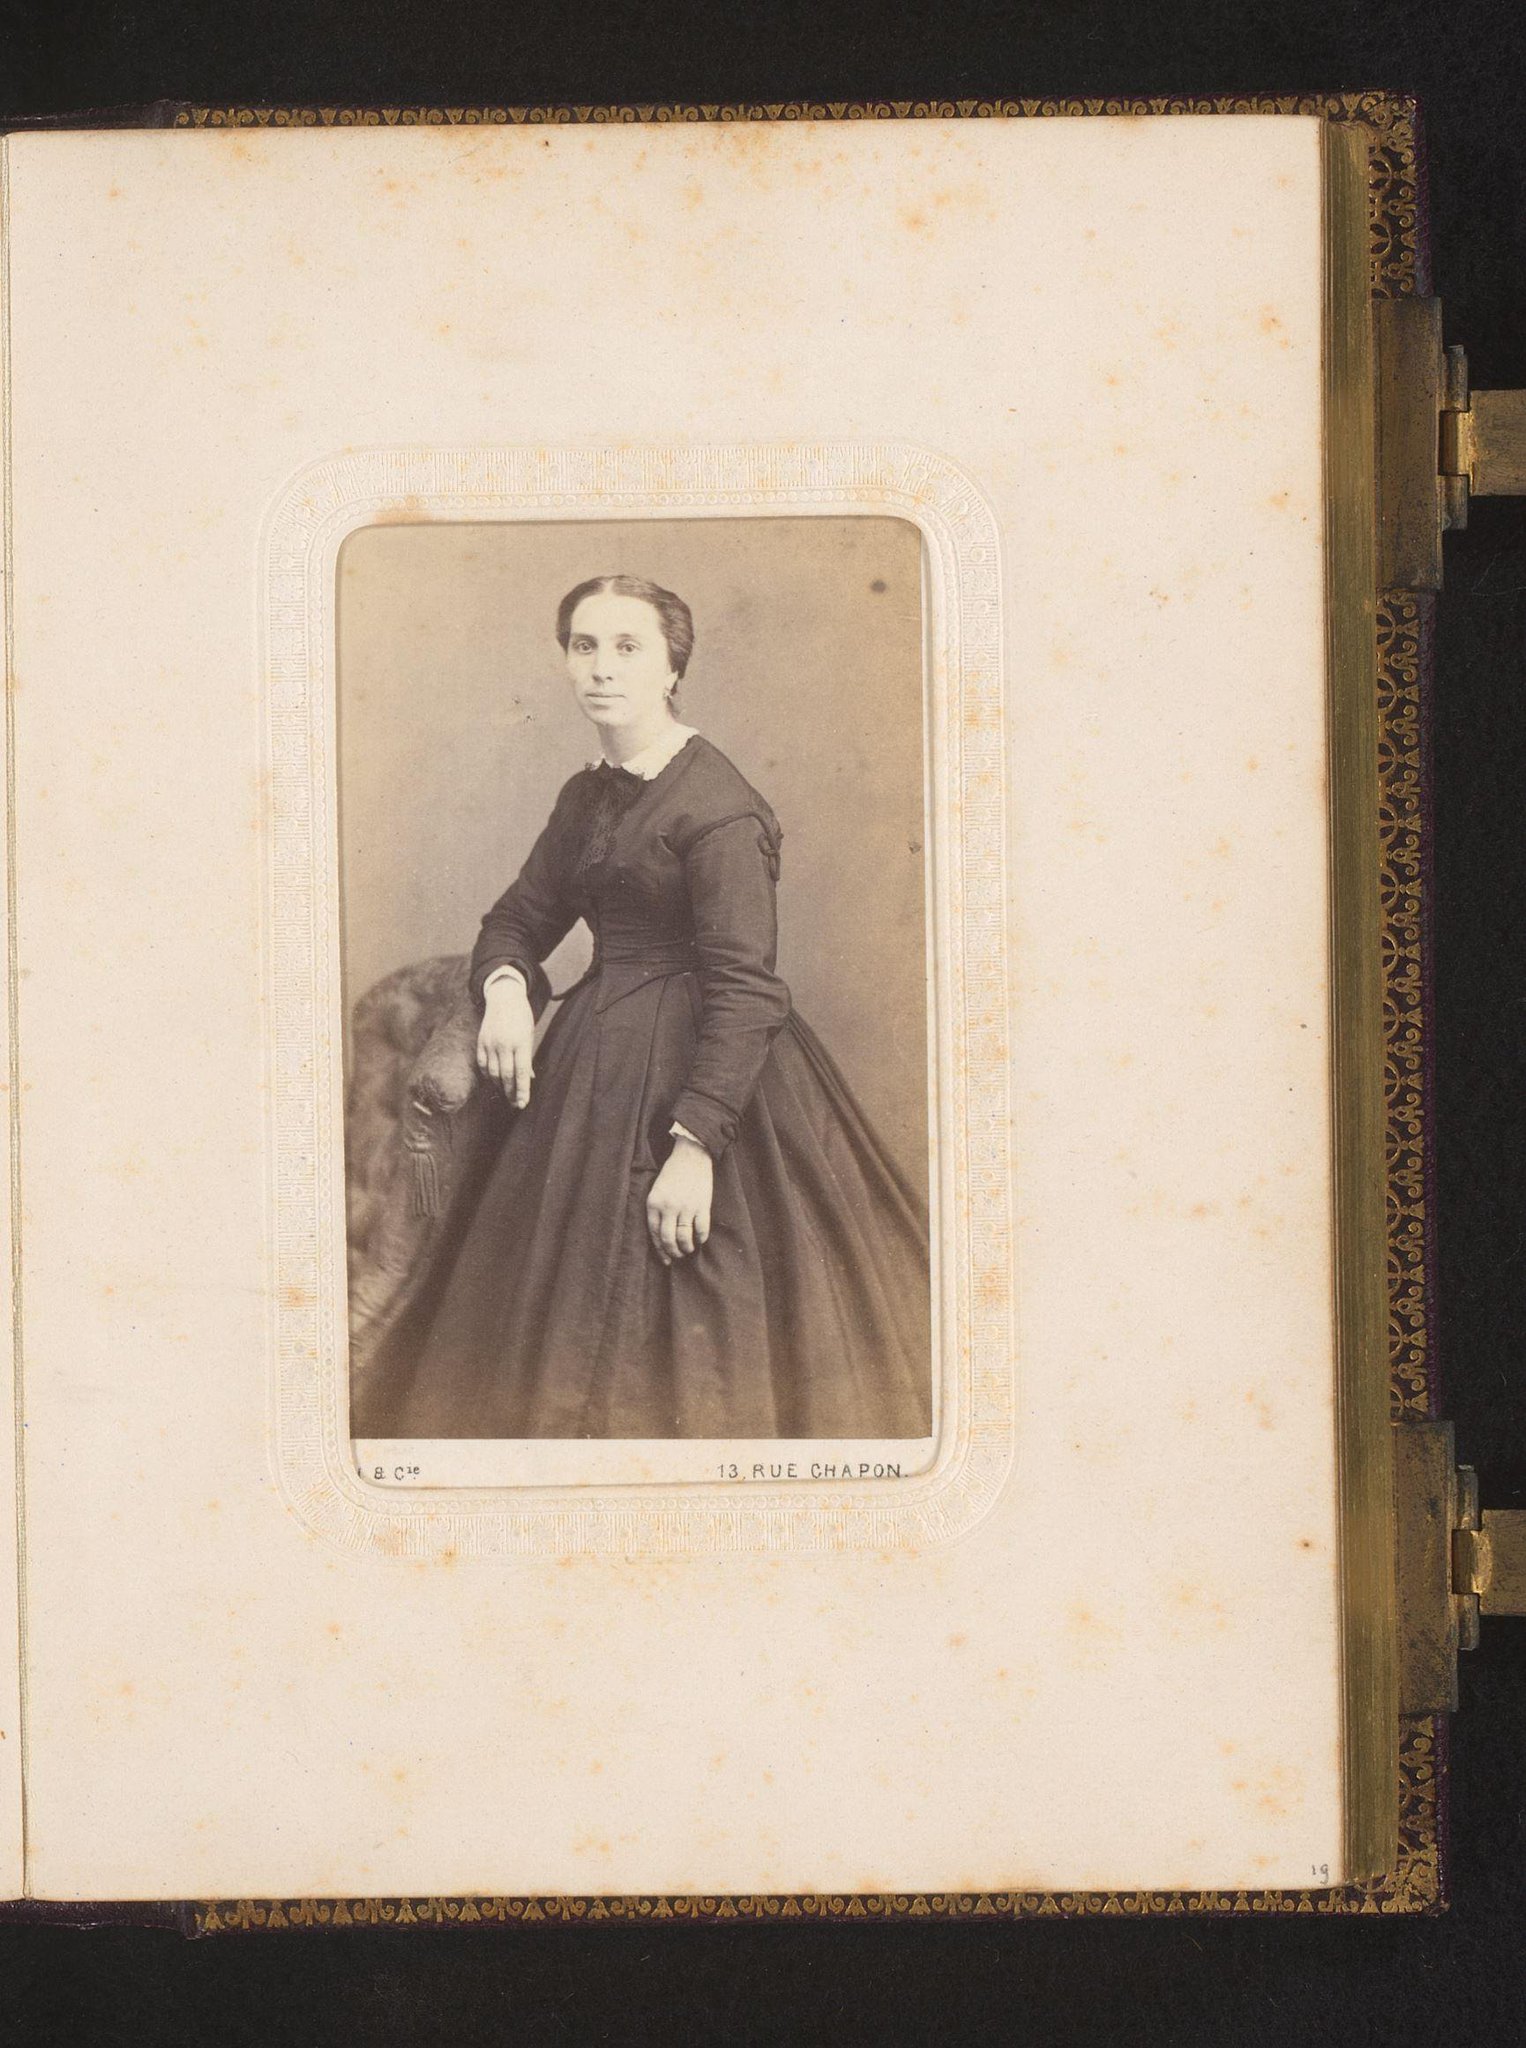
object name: album leaf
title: Portret van een vrouw, staand bij een stoel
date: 1860-1900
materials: cardboard, photographic support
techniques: albumen print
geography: paris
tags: historical persons - bb - woman, standing figure - aa - female human figure, chair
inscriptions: inscription: ‘PHOTOGRAPHIE/ JAMIN & Cie/ (Btes S.D.G.D.)/ 13, Rue Chapon, 13./ HÔTEL DE MONTBRISON/ Paris.’